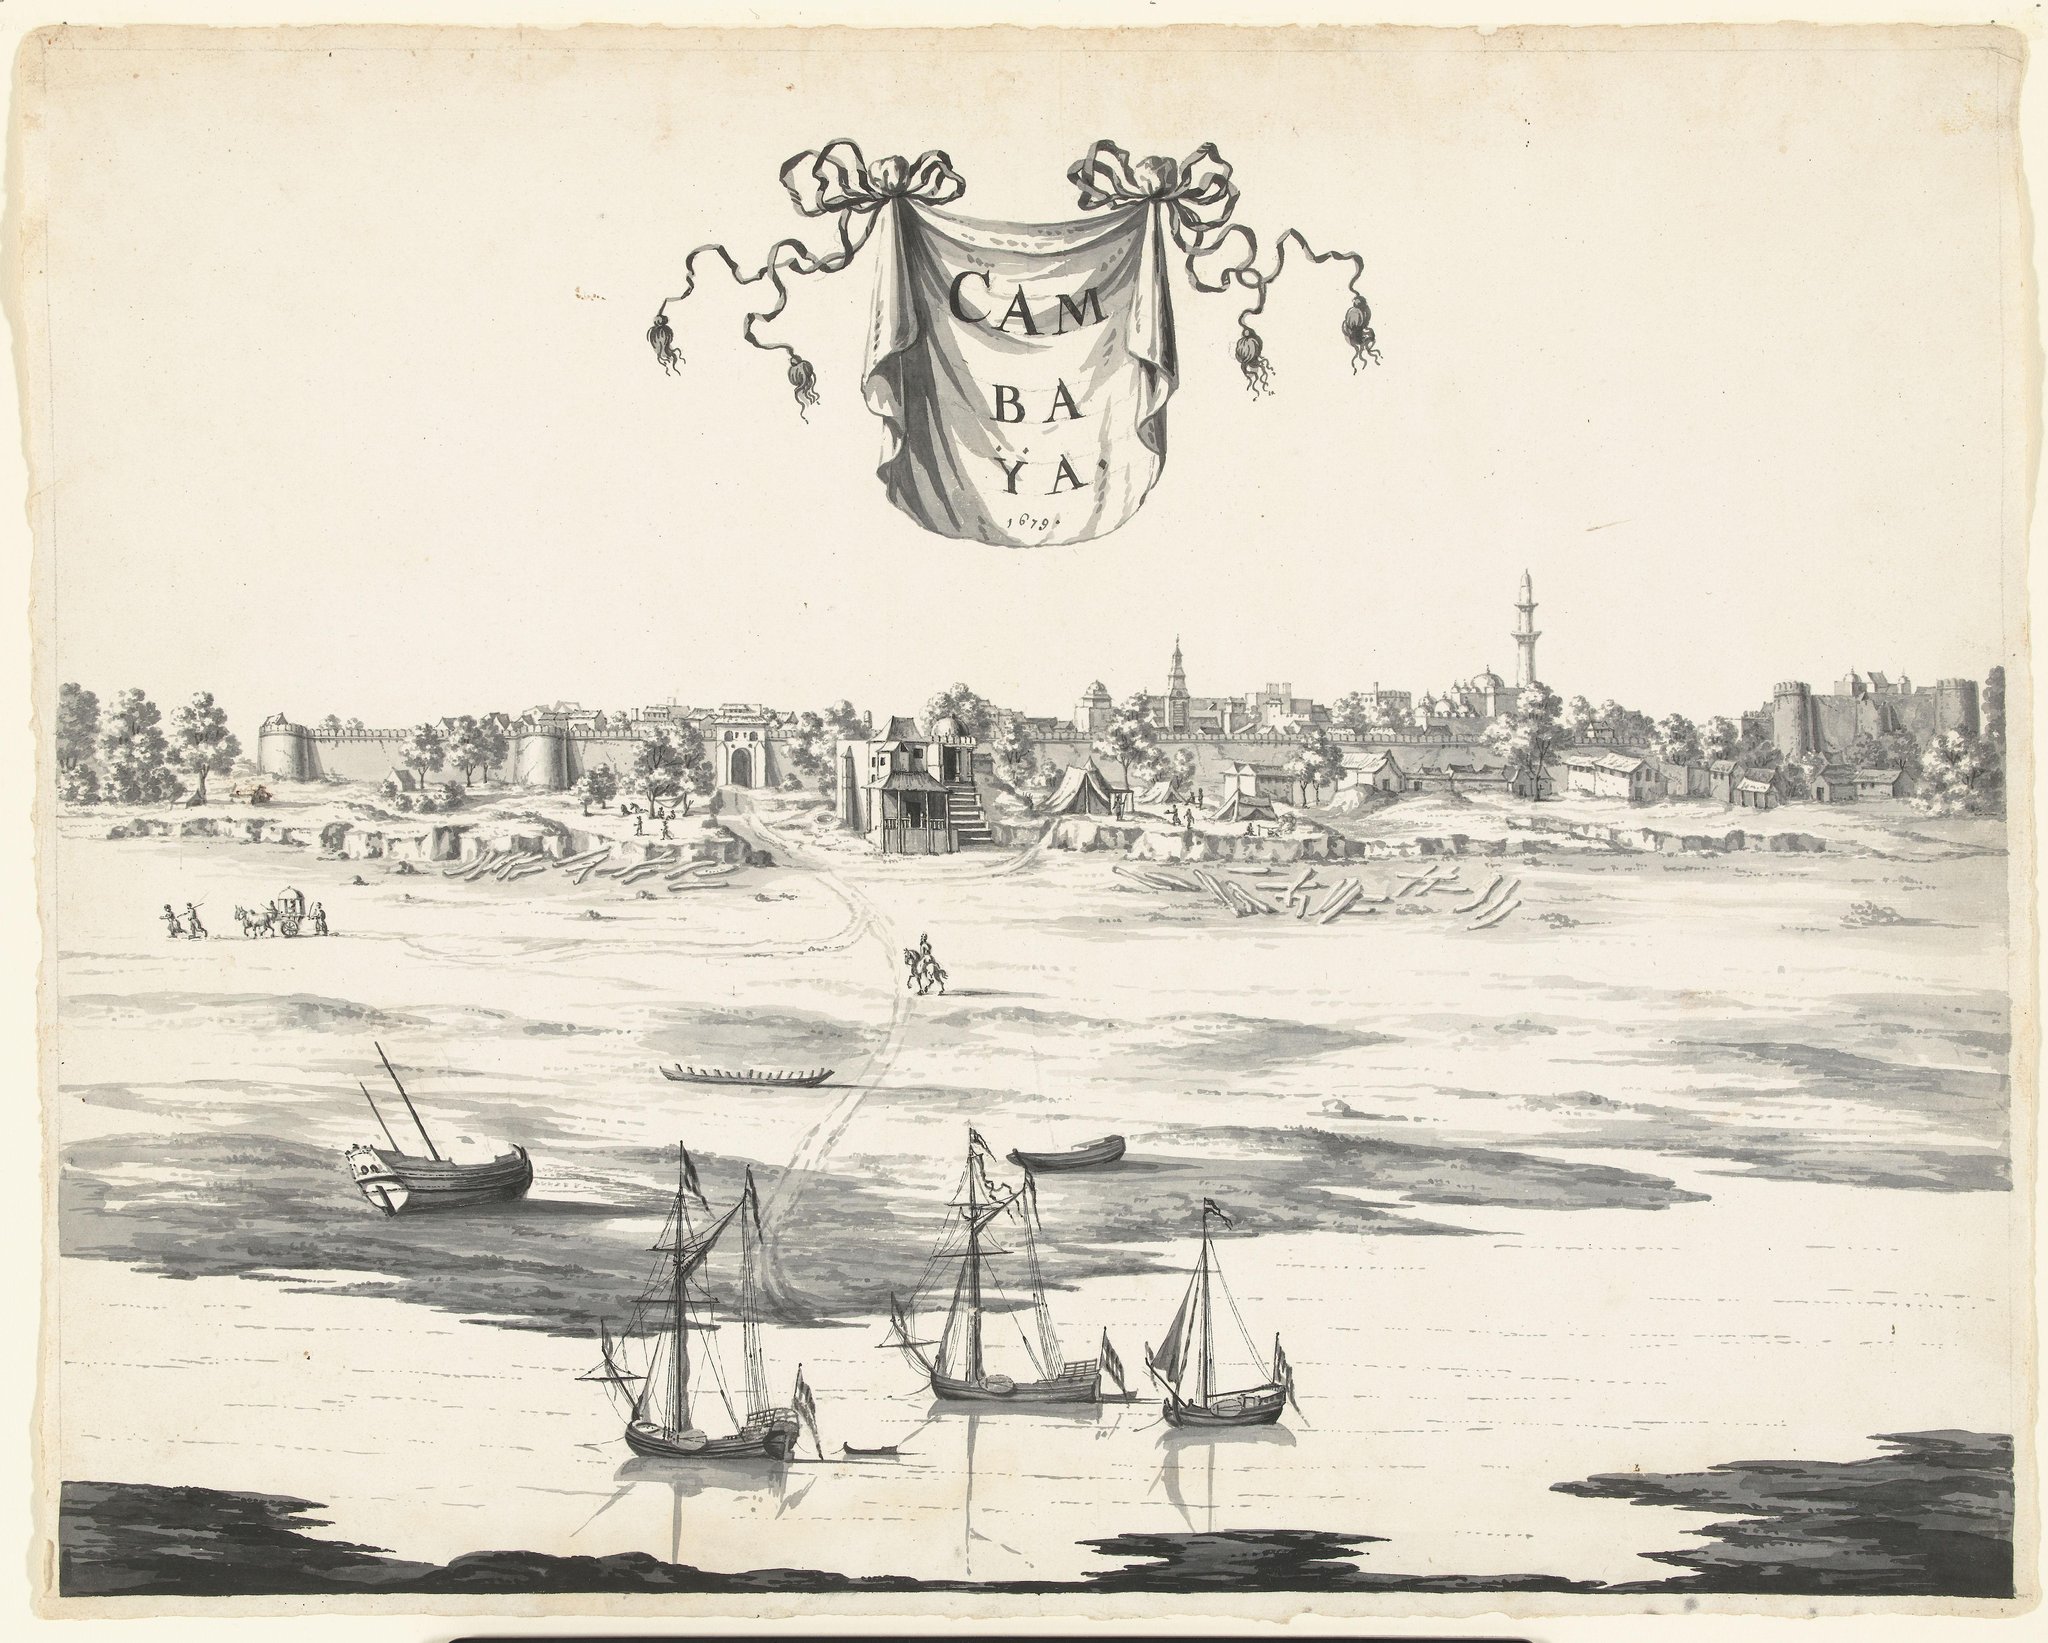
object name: drawing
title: Gezichten in India uit de jaren 1678-1679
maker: Anonymous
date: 1679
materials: paper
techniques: brush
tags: prospect of city, town panorama, silhouette of city, cambay